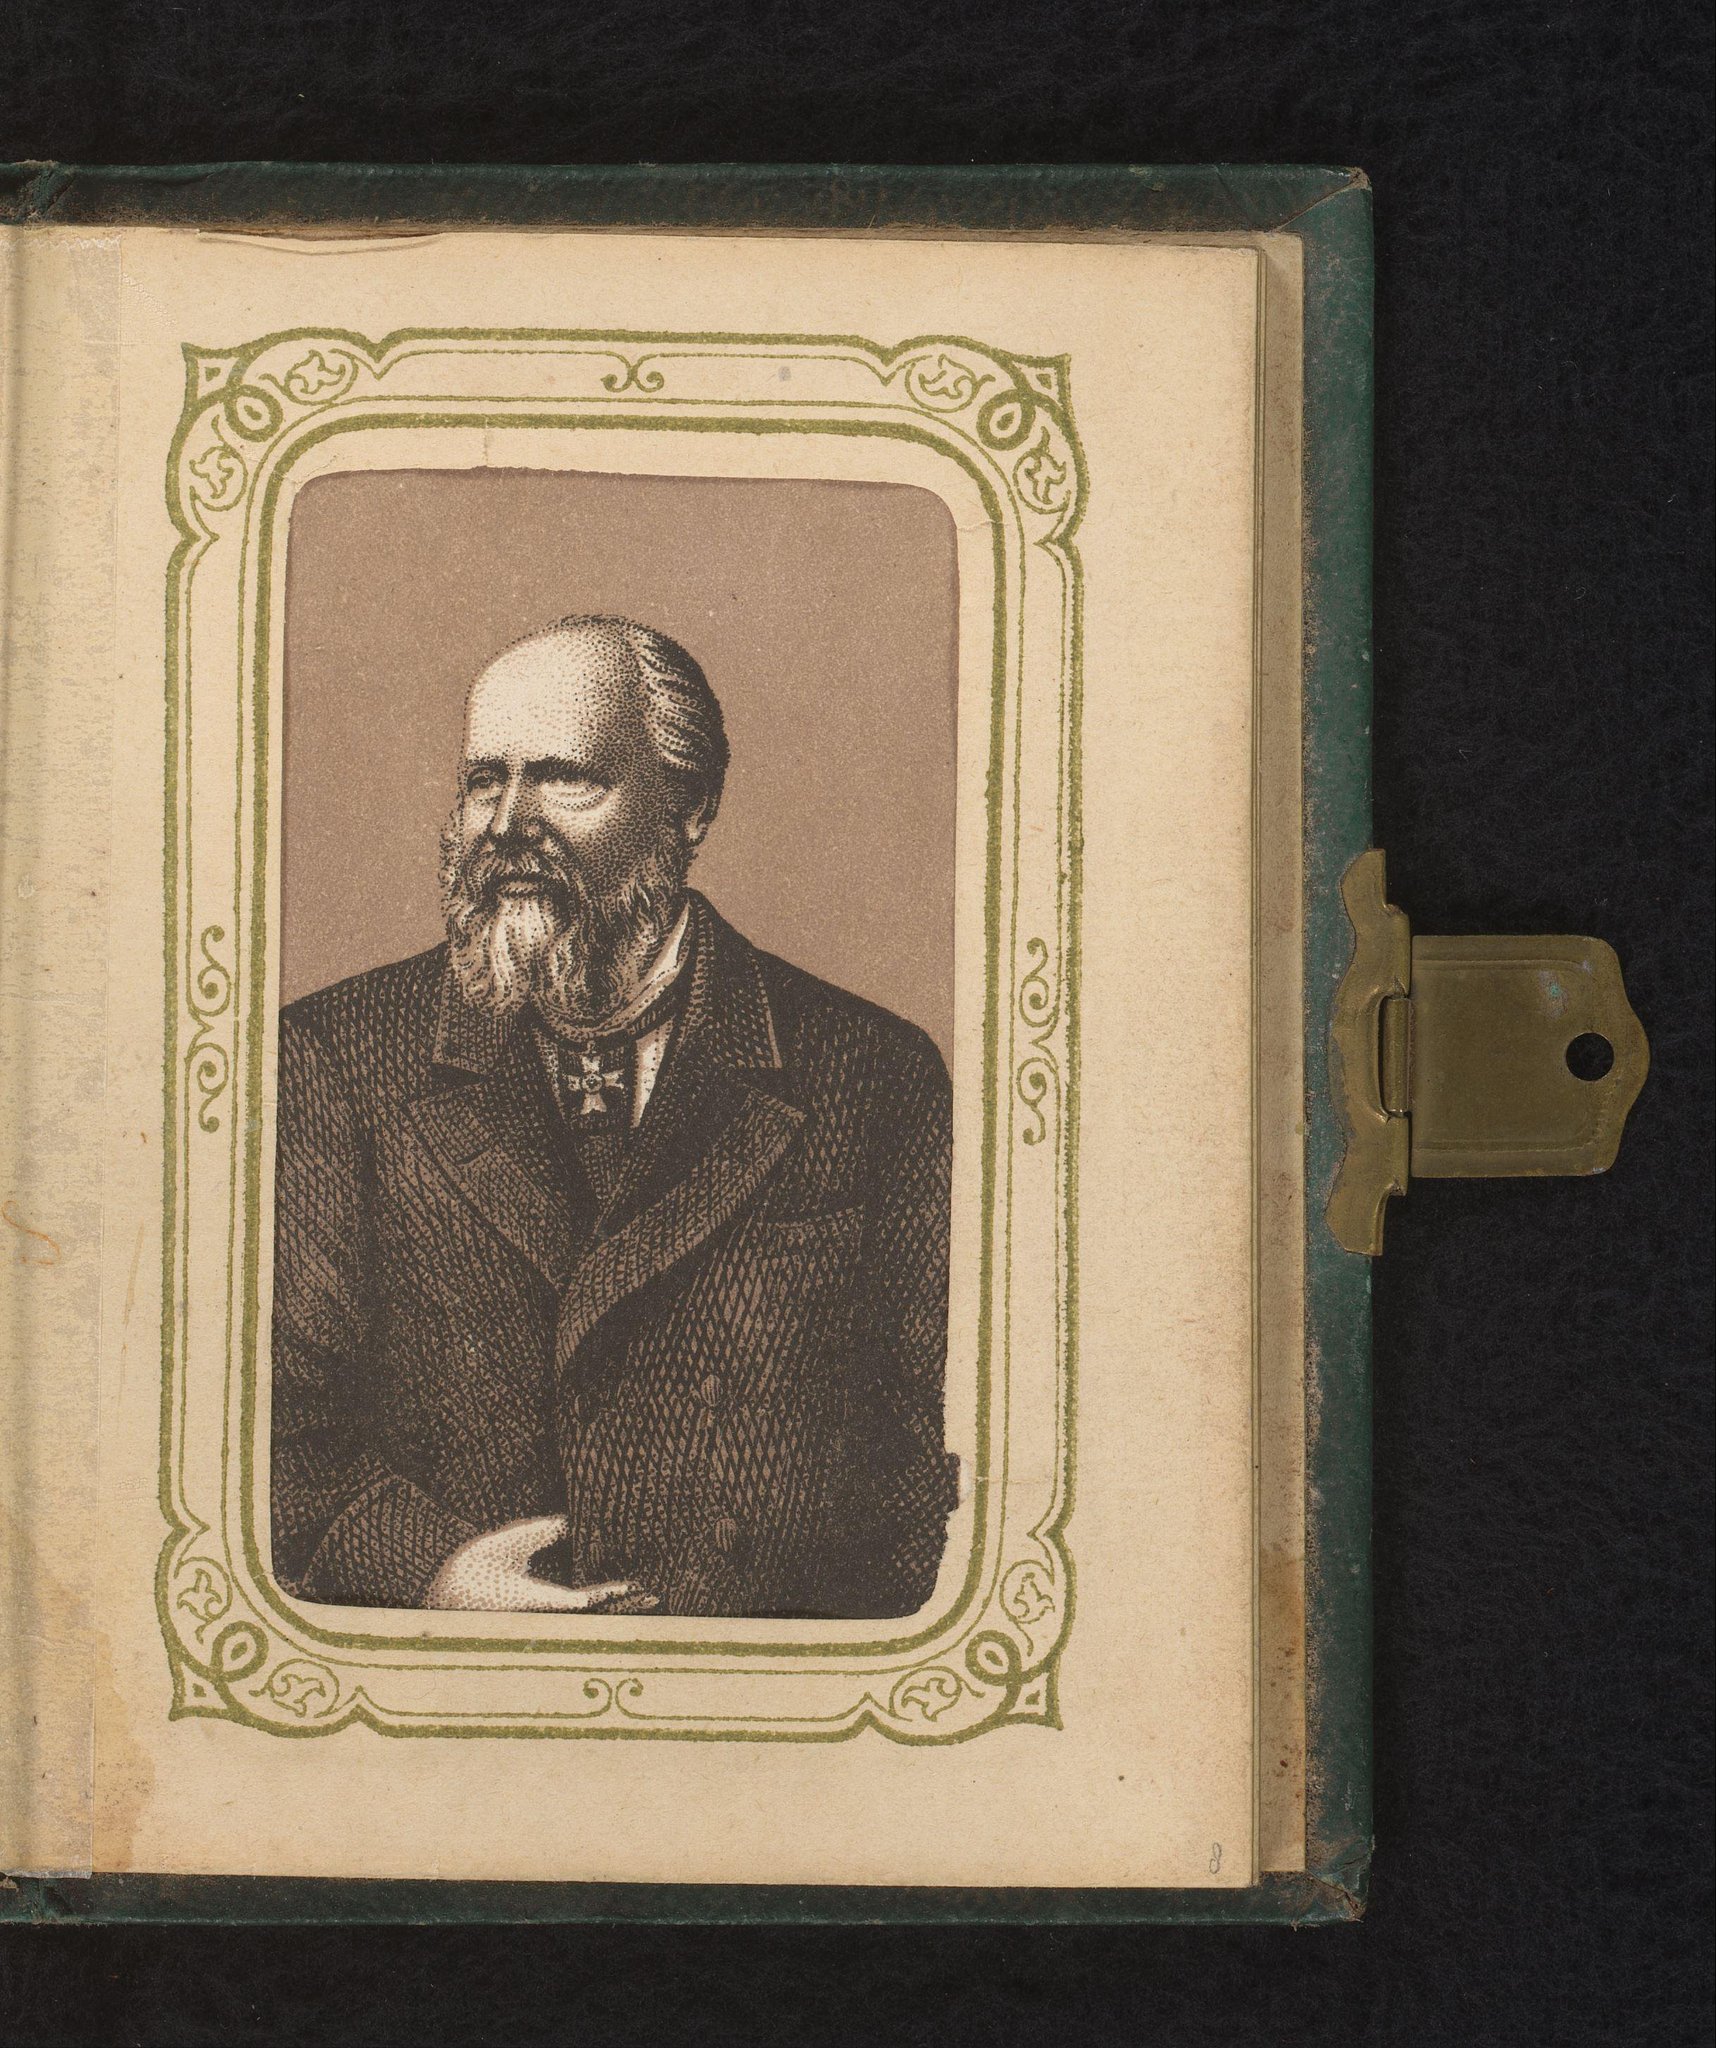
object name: print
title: Portret van Willem III, koning der Nederlanden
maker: Anonymous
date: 1860-1900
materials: paper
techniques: lithograph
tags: brussels, willem iii (koning der nederlanden), historical persons, king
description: Deze prent maakt deel uit van een album.